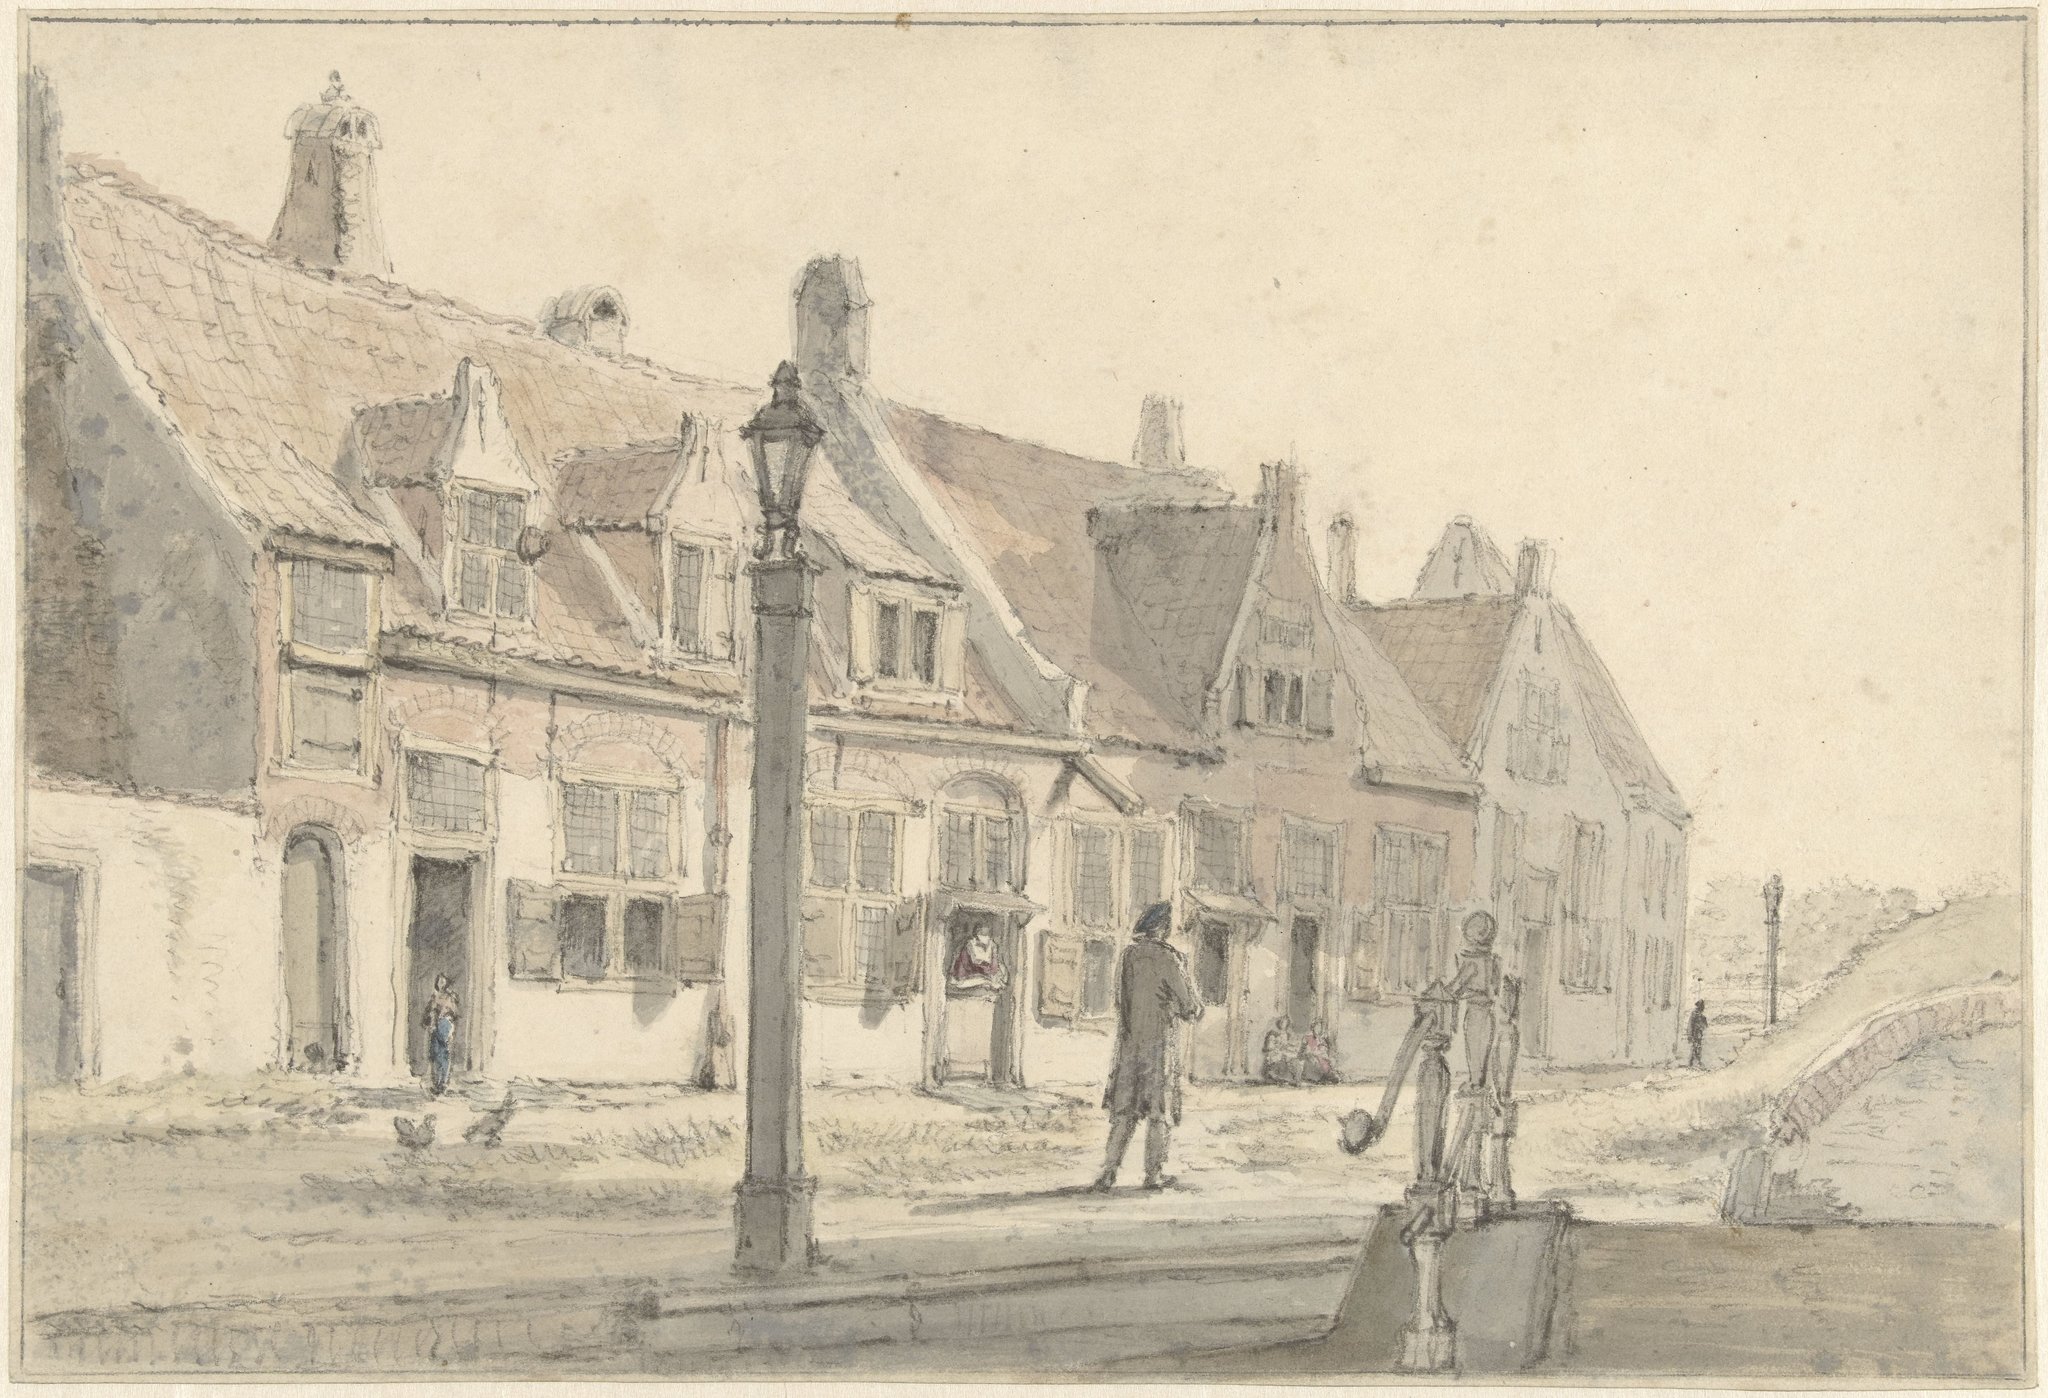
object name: drawing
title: Bij de Koepoort te Delft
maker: johannes jelgerhuis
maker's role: draughtsman, painter, print maker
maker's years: 1770-1836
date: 1807-1819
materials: chalk, paper, watercolor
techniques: brush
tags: street, delft